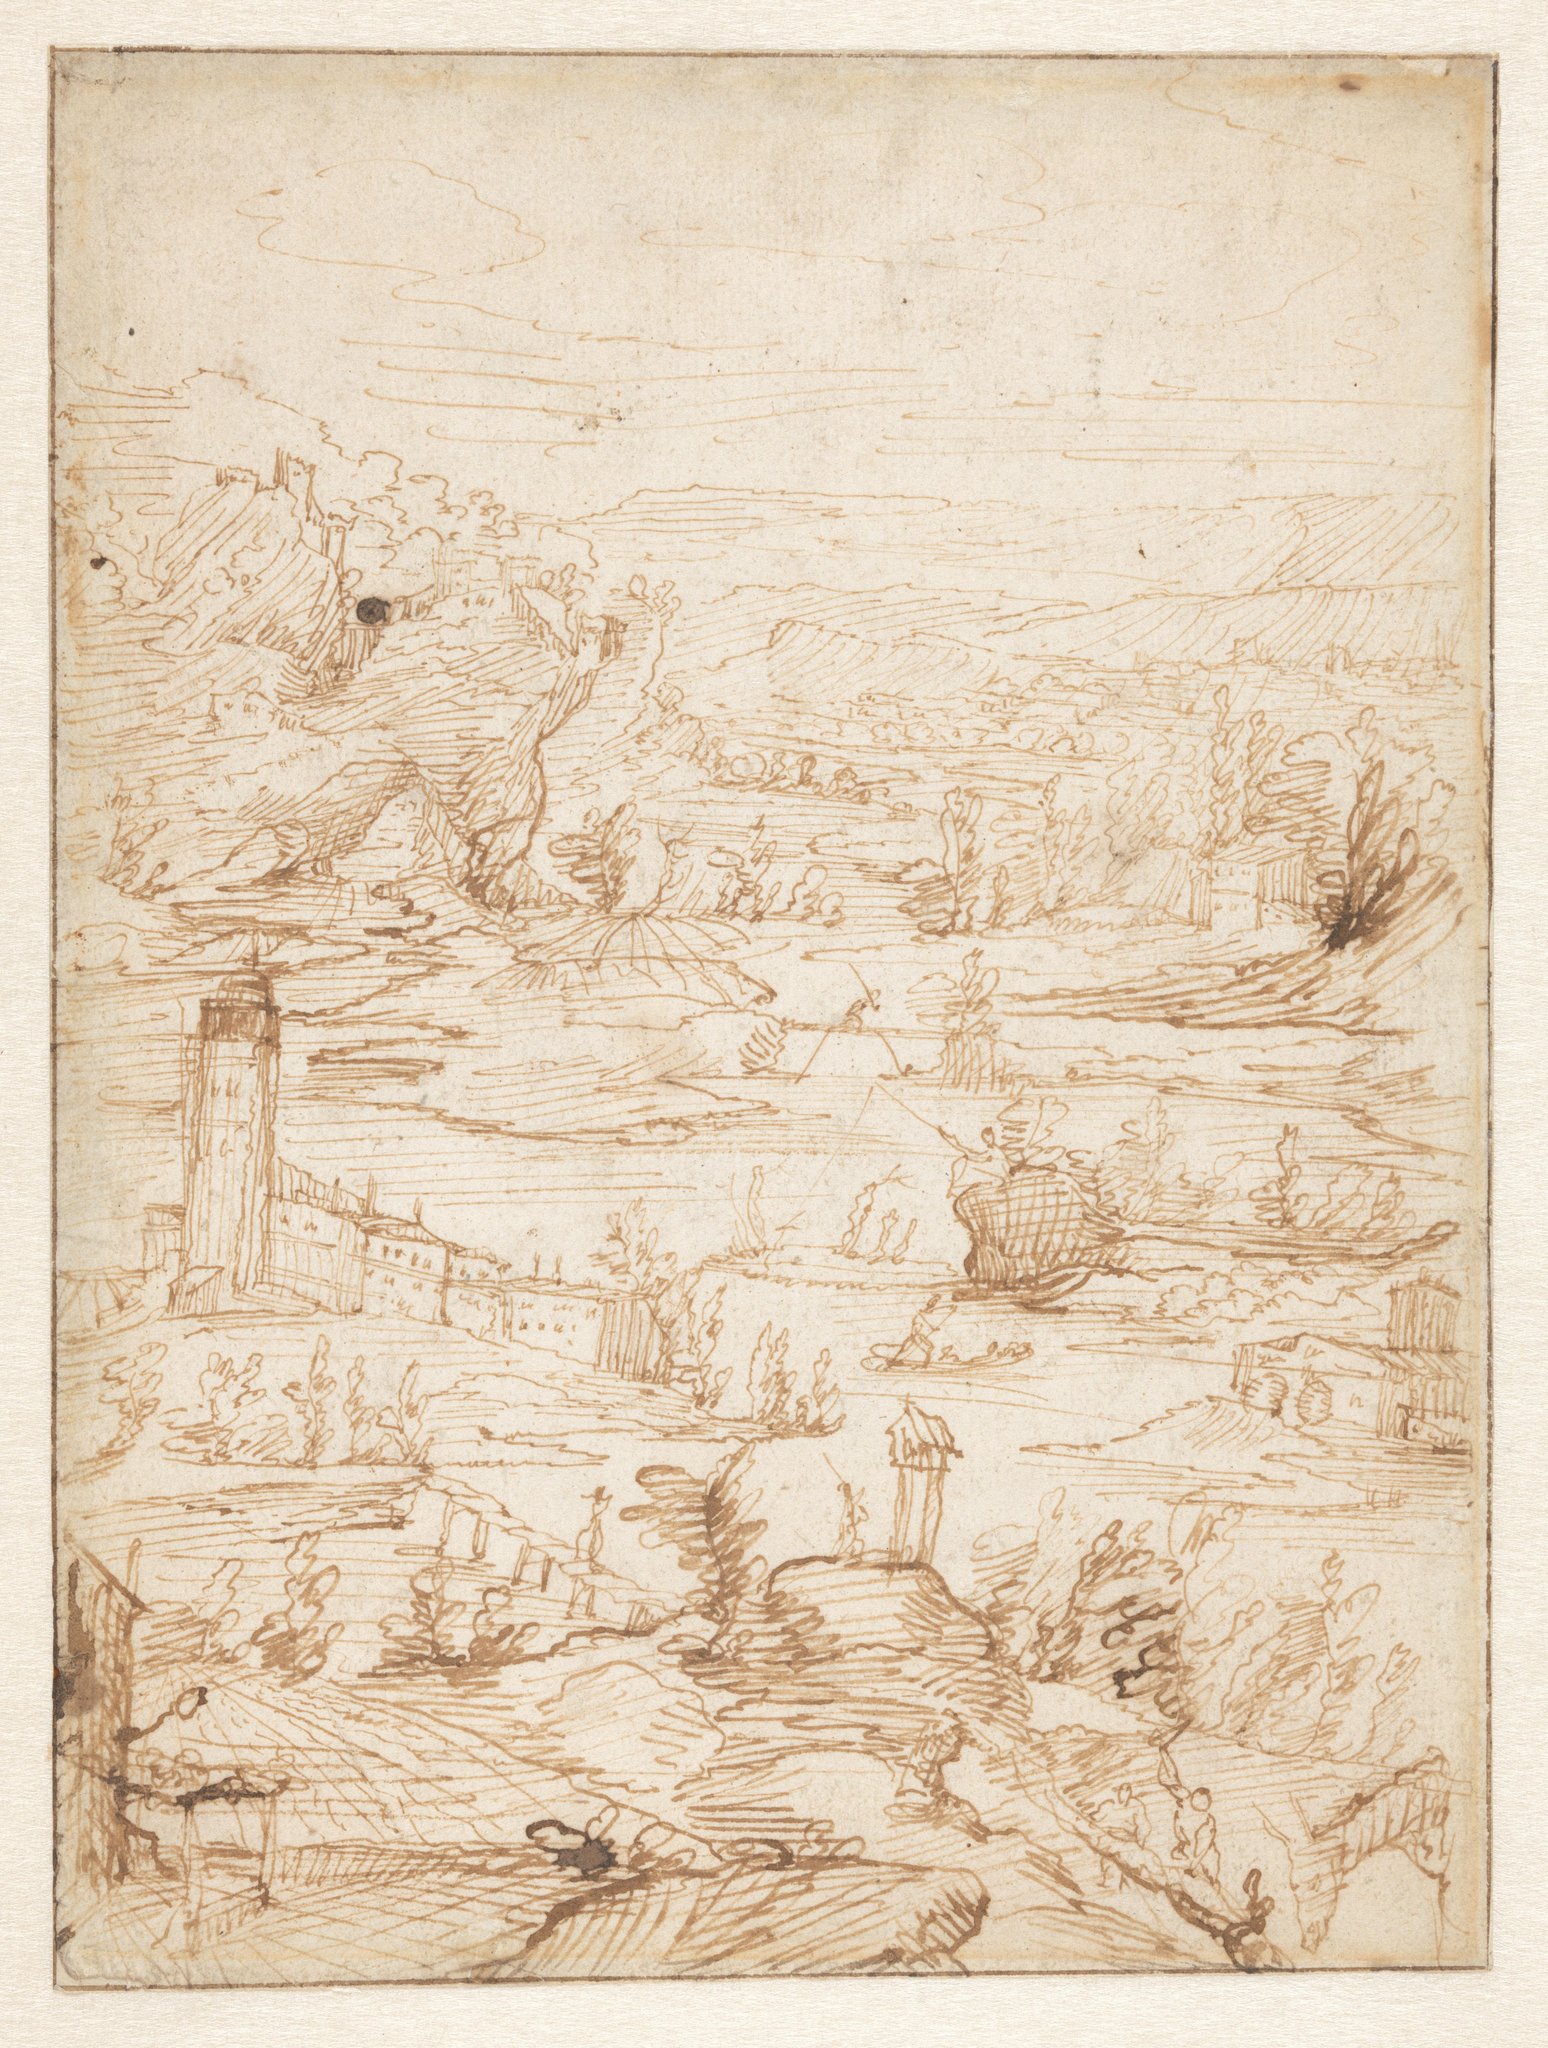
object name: drawing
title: Studieblad met berglandschap en gebouwen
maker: lodewijk toeput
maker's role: draughtsman, print maker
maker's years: 1550-1603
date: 1601-1604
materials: paper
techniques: pen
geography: treviso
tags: landscape with tower or castle, mountains